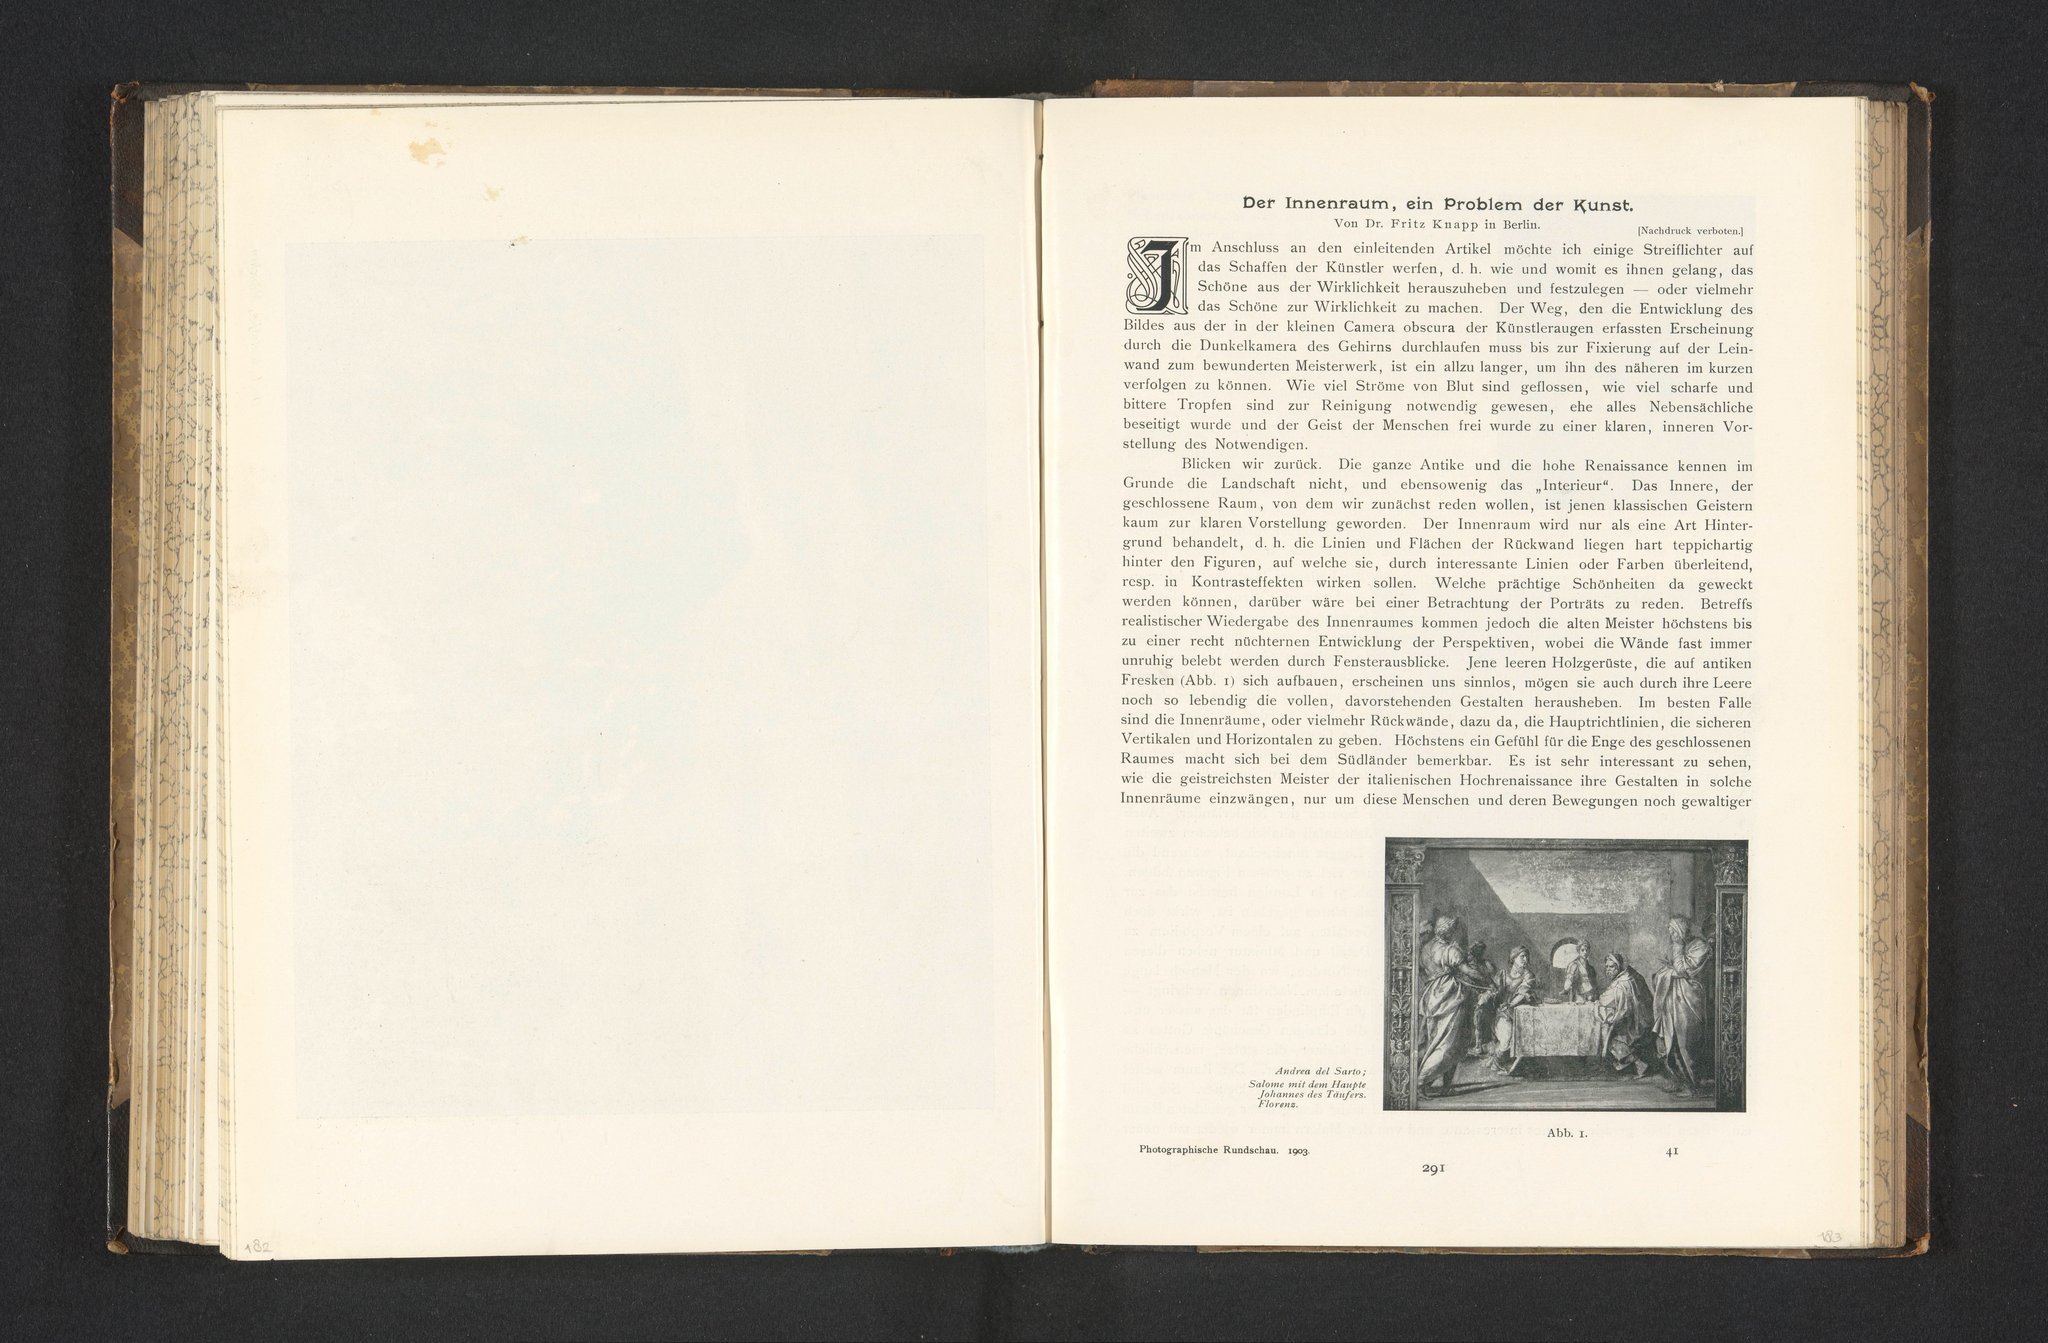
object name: reproduction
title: Reproductie van het fresco Het feest van Herodes door Andrea del Sarto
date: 1898-1903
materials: paper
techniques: autotype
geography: florence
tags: the head of john the baptist brought to or lying on the banqueting table